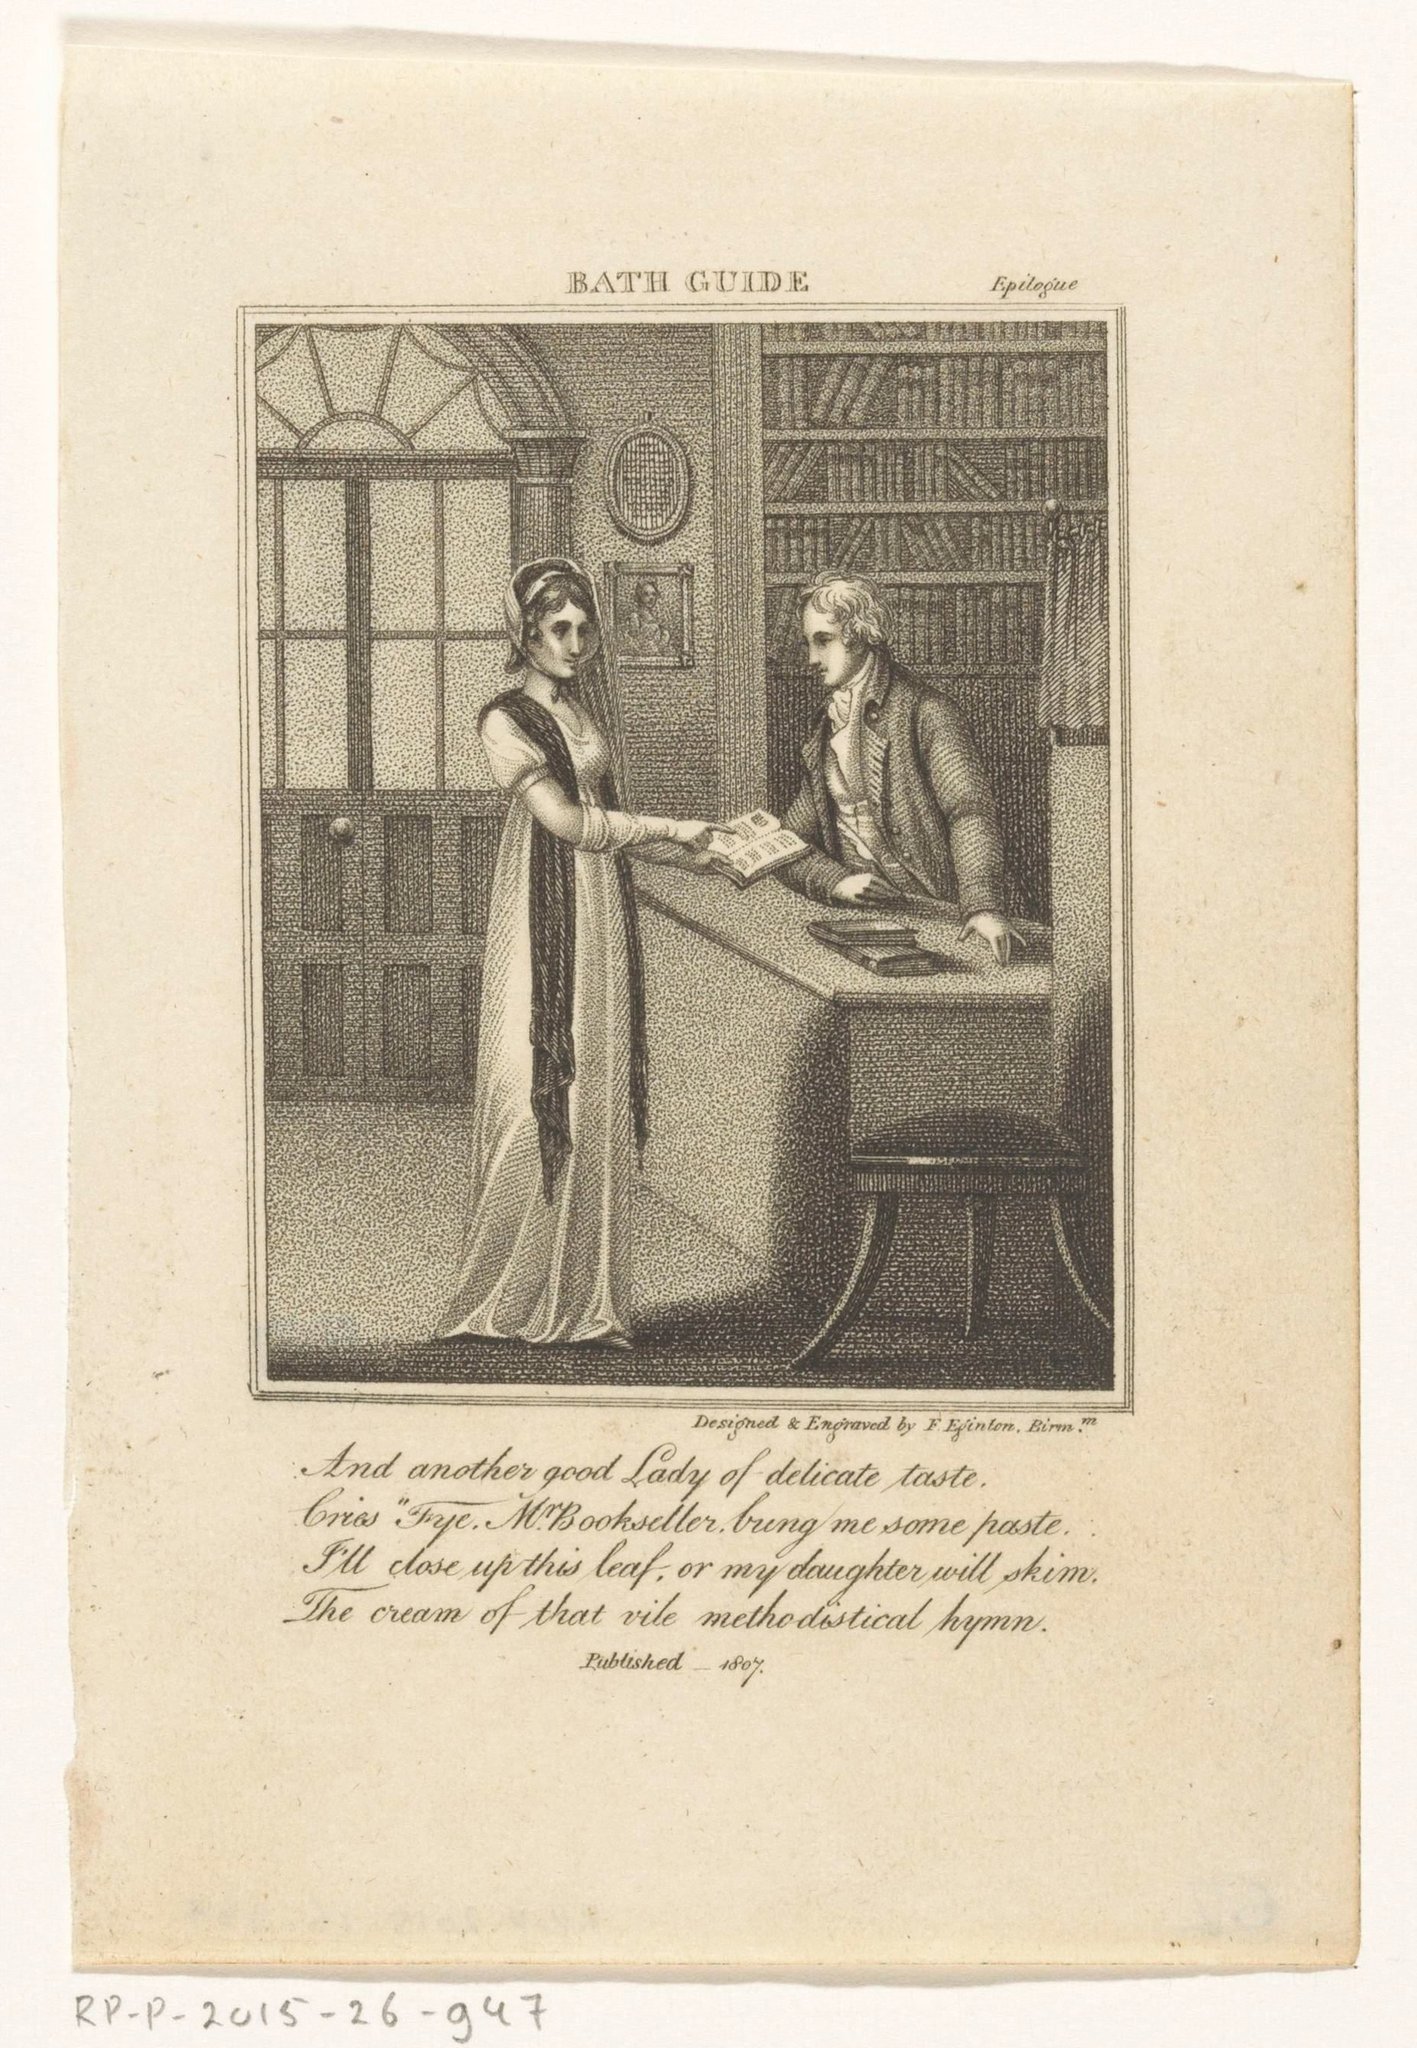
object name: print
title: Vrouw in een boekhandel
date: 1807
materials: paper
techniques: stippled etching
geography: birmingham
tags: book-shop, bookseller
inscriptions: collector's mark: Lugt 2228, collector's mark: Lugt 4780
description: Prent afkomstig uit: [Anstey, Christopher]. The New Bath Guide or Memoirs of the B.N.R.D. Family in a Series of Poetical Epistles. Bath: John Browne, 1807, tussen p. 88-89.